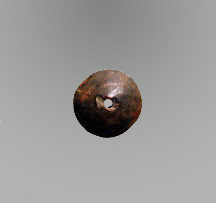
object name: disk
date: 600-401 BCE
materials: amber